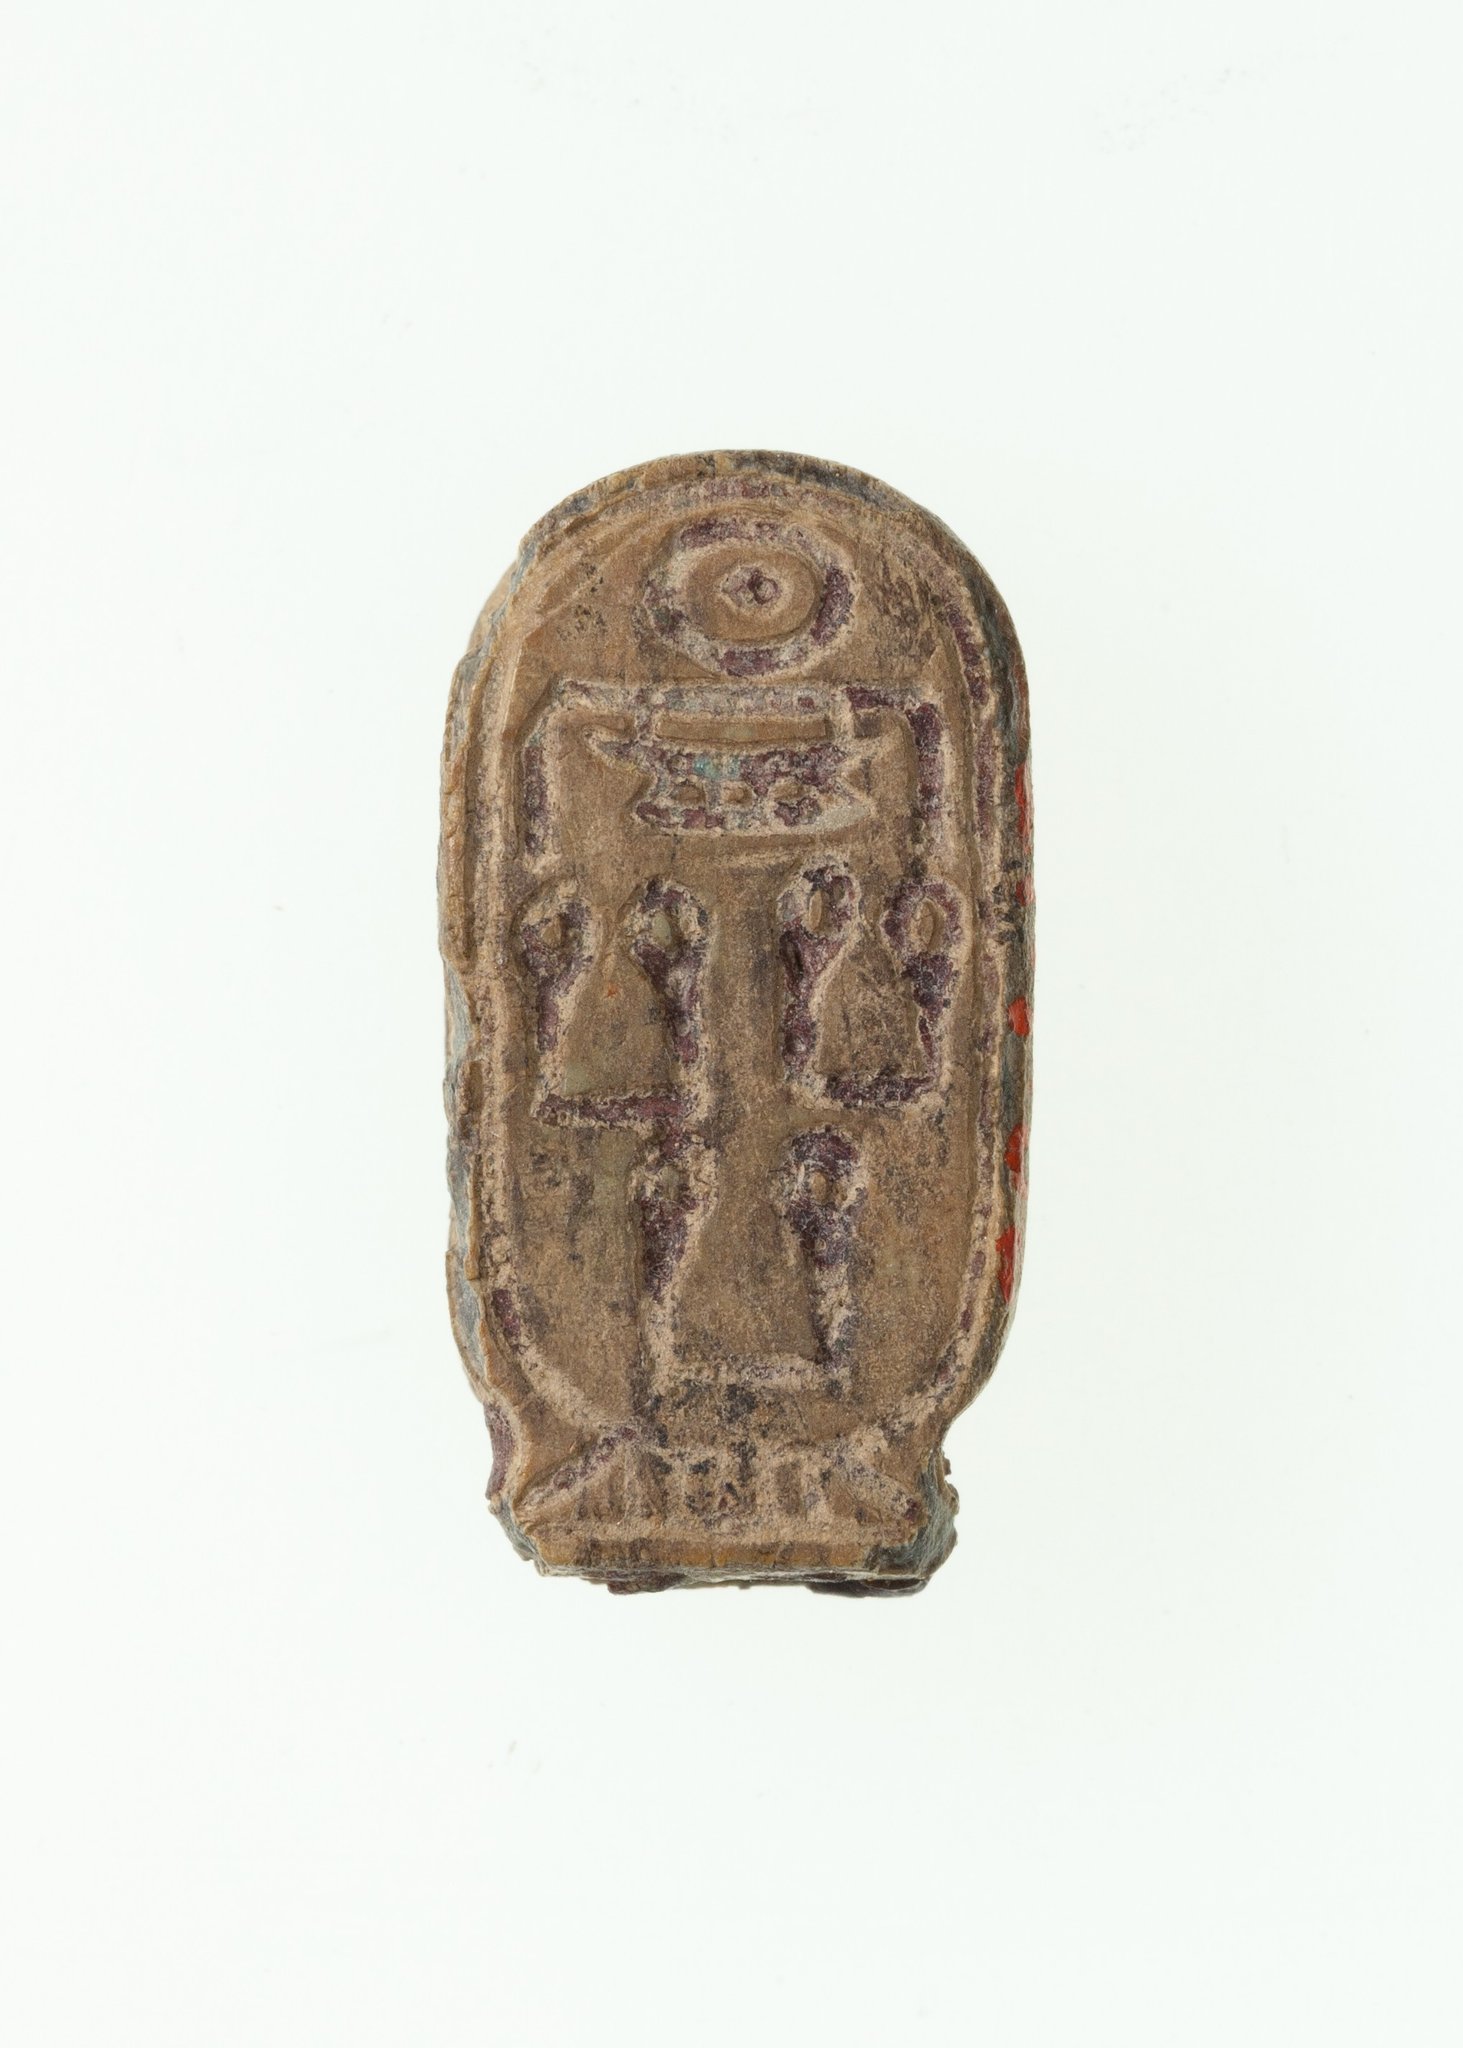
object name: plaque, amenemhat ii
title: Plaque of Amenemhat II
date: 1919-1885 BCE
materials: stone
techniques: glazing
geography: egypt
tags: hieroglyphs